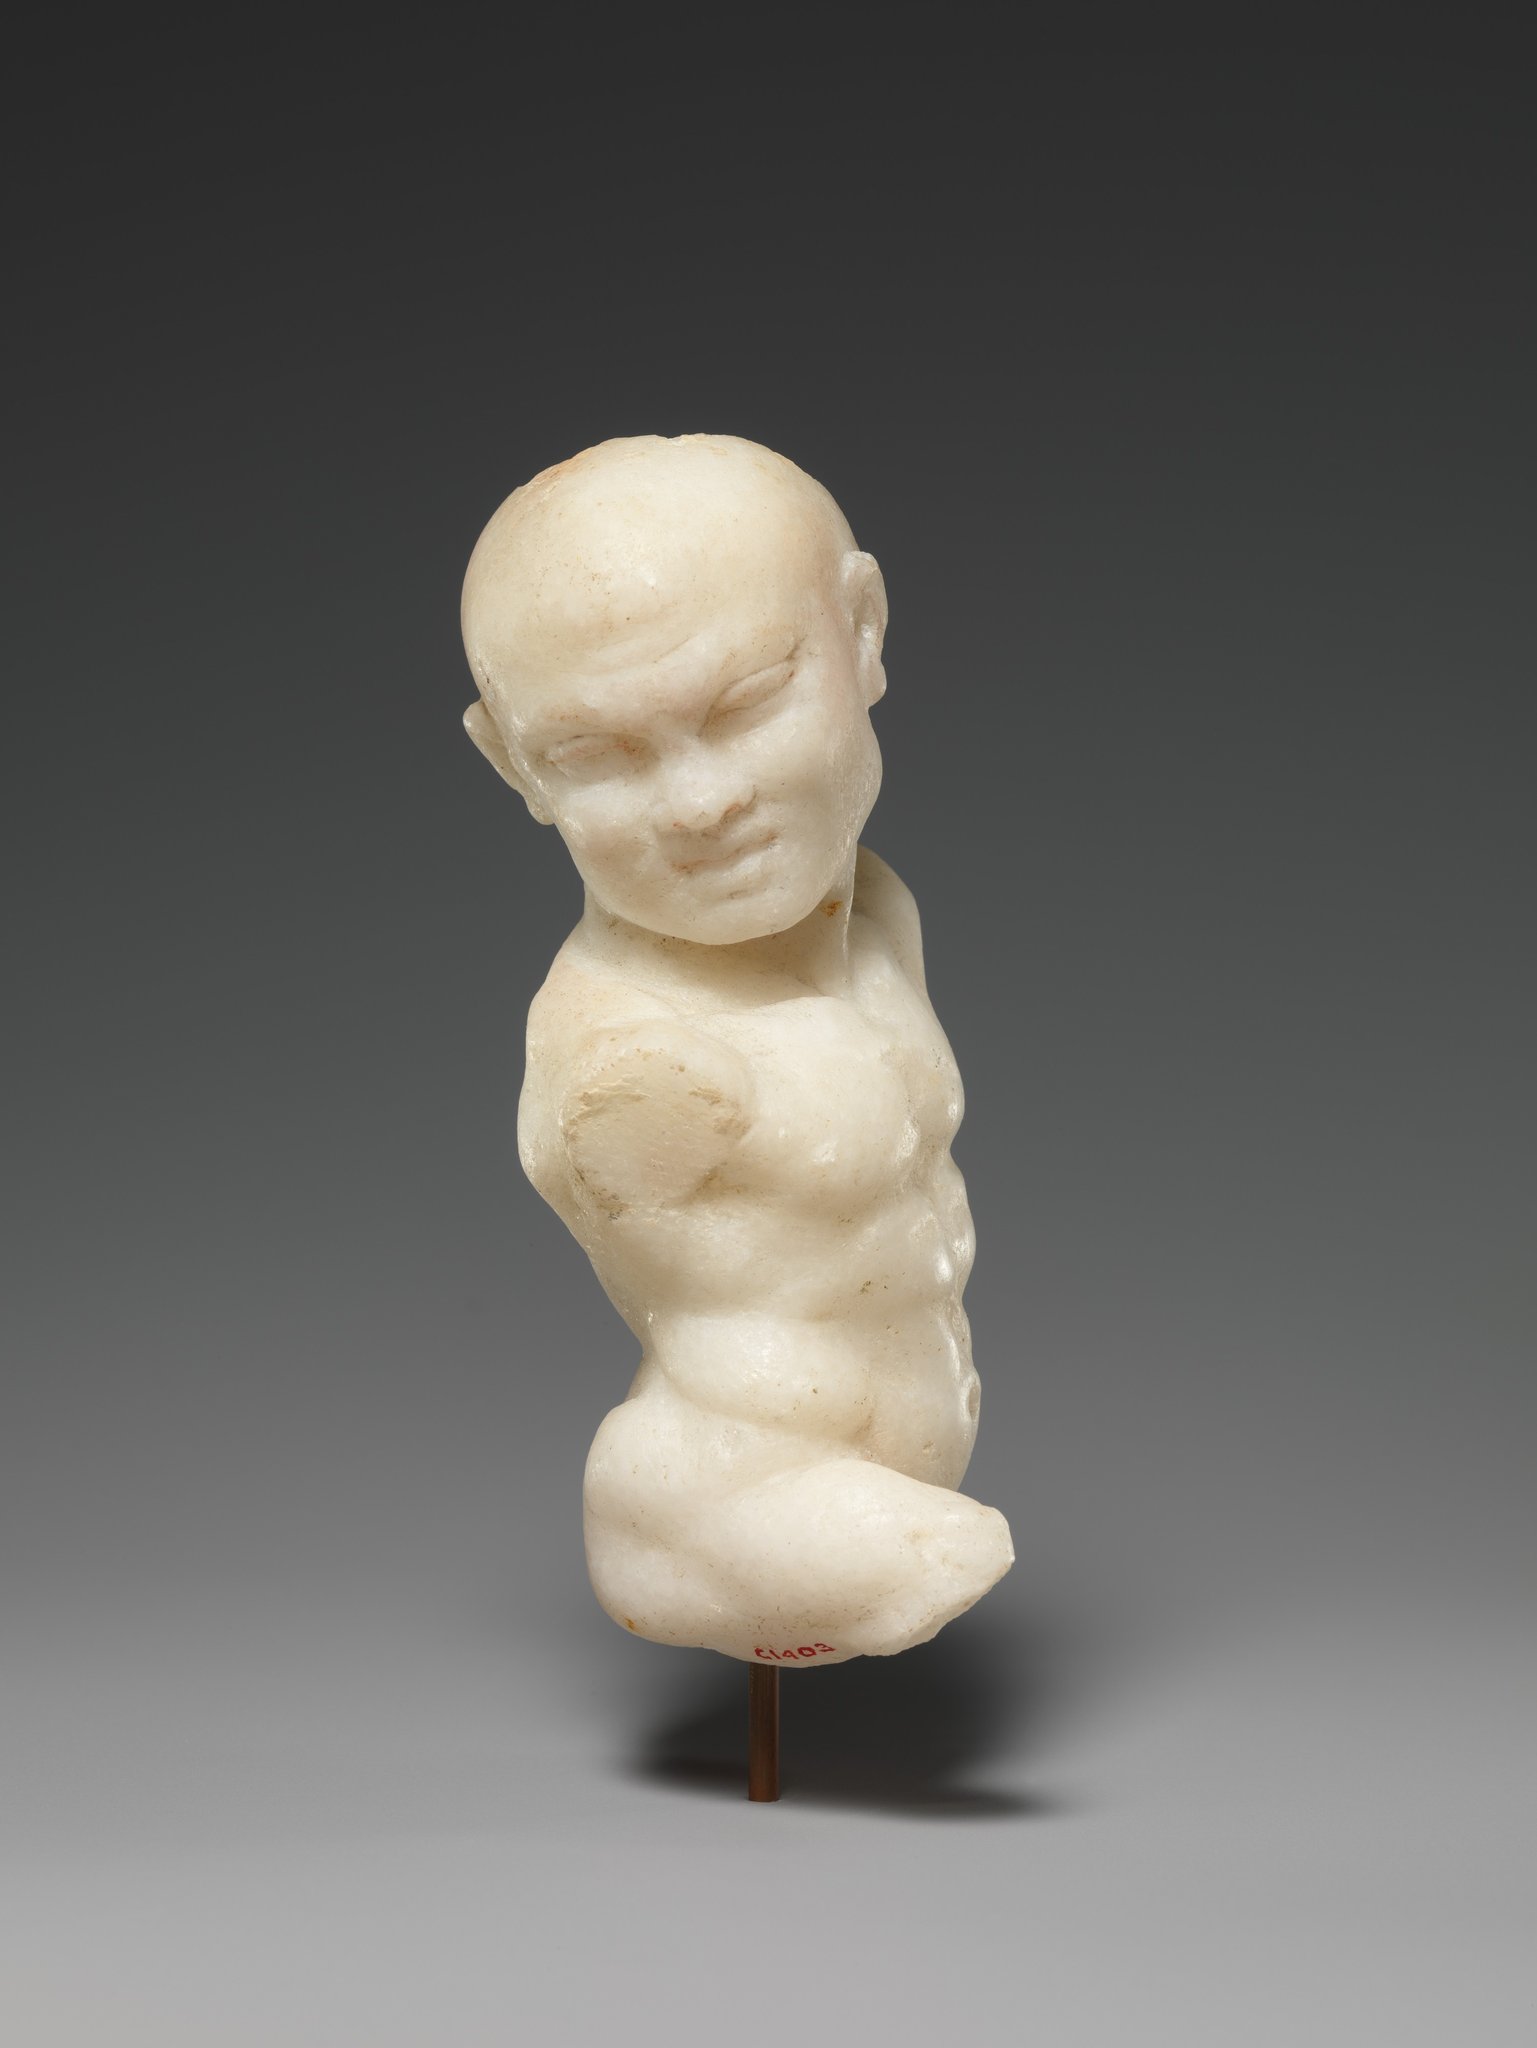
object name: statuette, dwarf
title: Dancing dwarf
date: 332-150 BCE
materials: marble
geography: egypt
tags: men,dancing